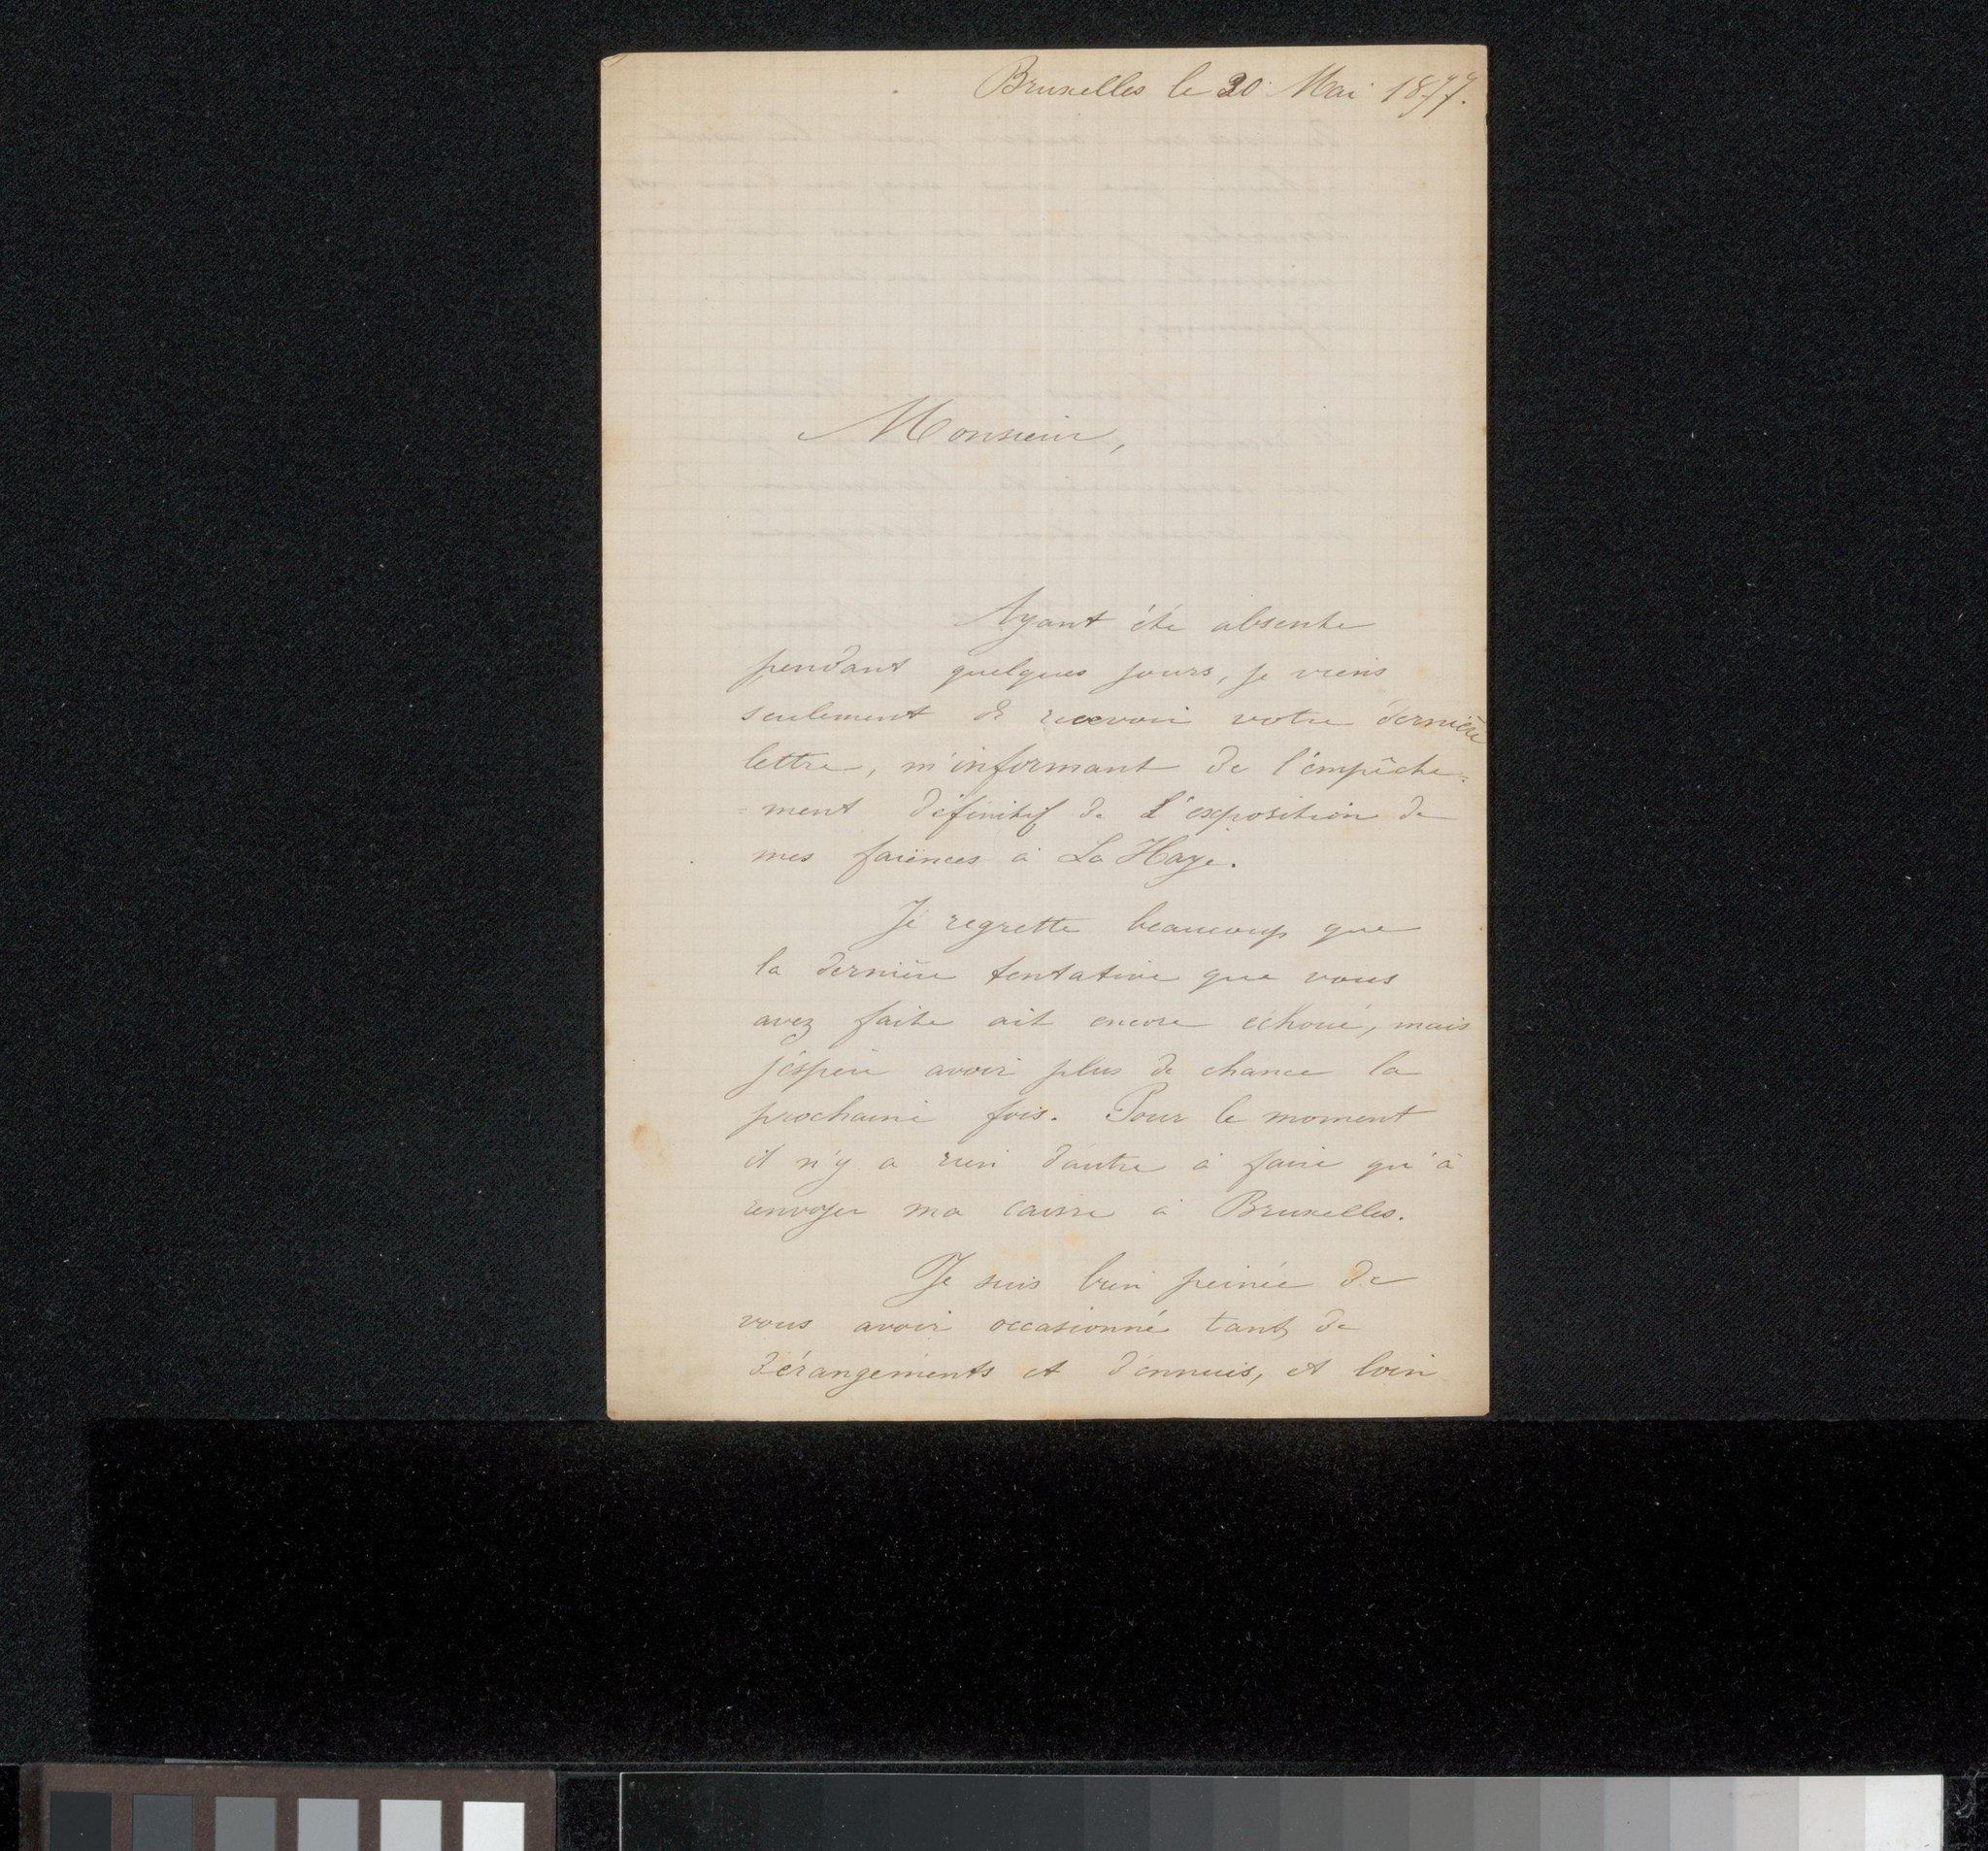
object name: letter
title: Brief aan Philip Zilcken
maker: georgette meunier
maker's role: painter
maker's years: 1859-1951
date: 1877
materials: ink, paper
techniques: pen, writing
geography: brussels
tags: the hague, draughtsman, philip zilcken, applied arts, arts and crafts; industrial design, exhibition ~ art, brussels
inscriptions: collector's mark: ‘RPK’